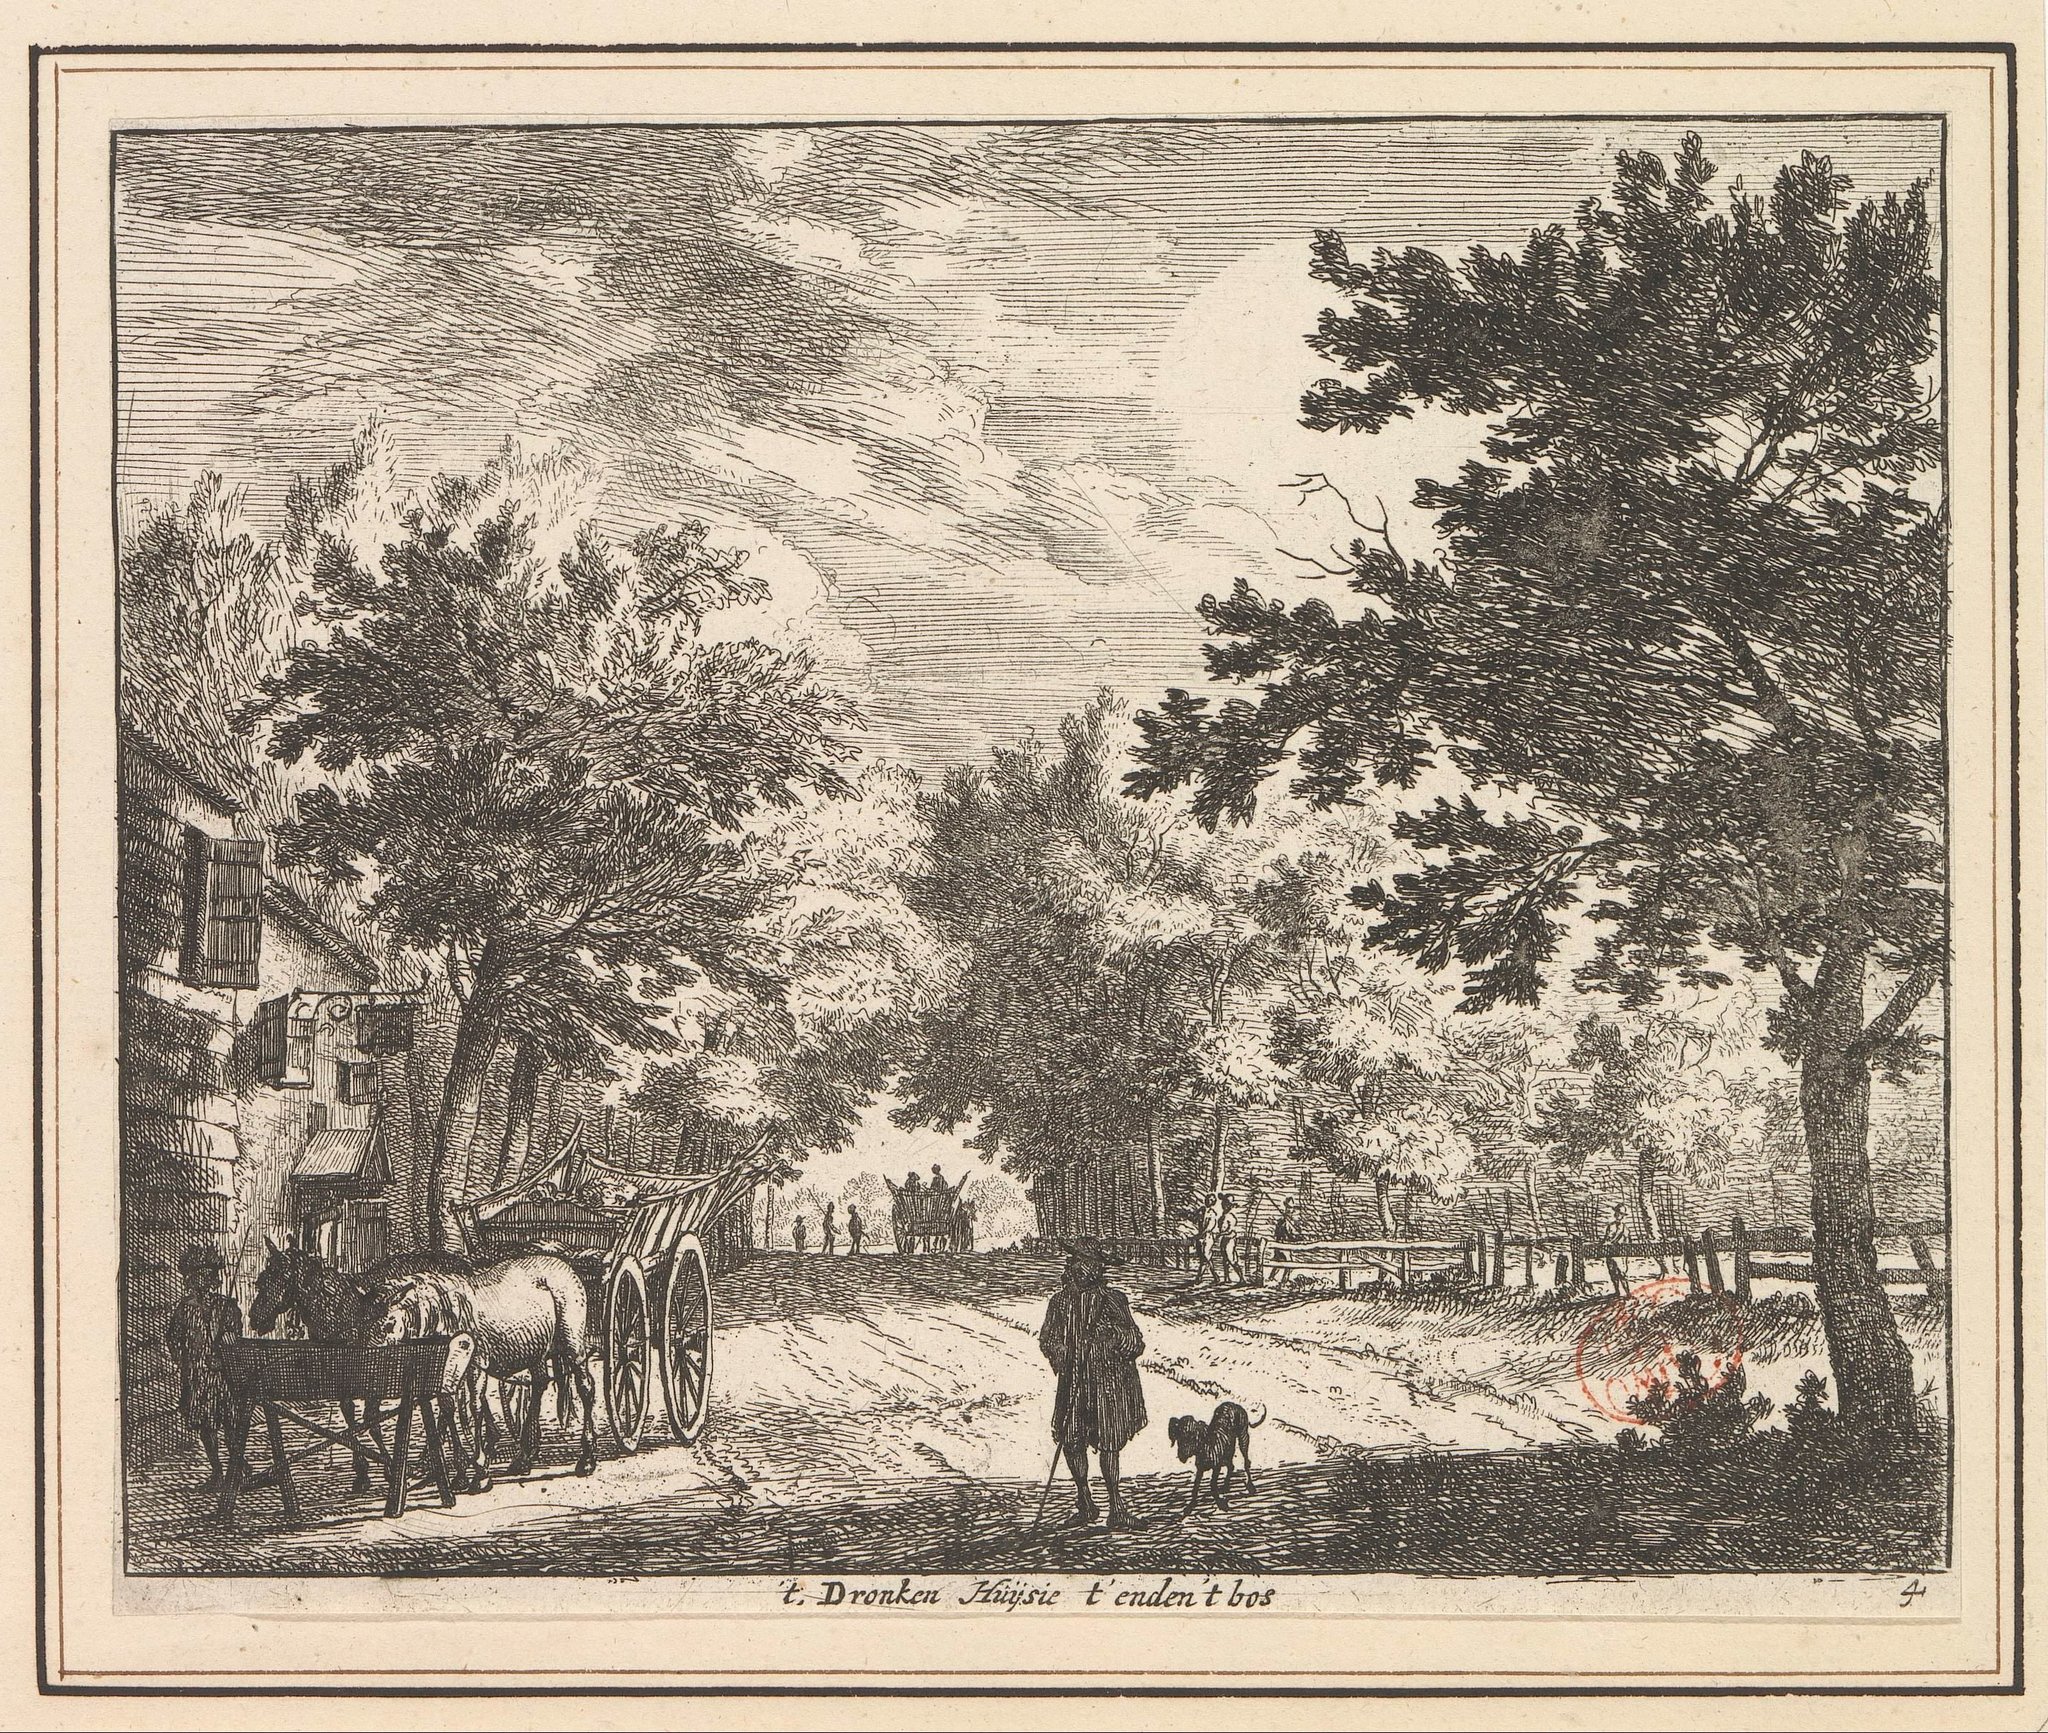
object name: print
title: Gesigten buijten Haarlem, Gedaan door. J.V.V.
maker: jan vincentsz. van der vinne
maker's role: draughtsman, print maker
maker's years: 1663-1721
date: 1688-1690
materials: paper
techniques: etching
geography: haarlem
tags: forest path or lane (+ landscape with figures, staffage), hotel, hostelry, inn, (farm) wagon, freight wagon, cart, haarlem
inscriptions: collector's mark: Lugt 195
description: Bij een herberg staat een boerenkar, waarvan de ingespannen paarden eten uit een ruif. Een wandelaar met een hond op de voorgrond. In de verte nog een kar met figuren. Rechtsonder genummerd: 4.